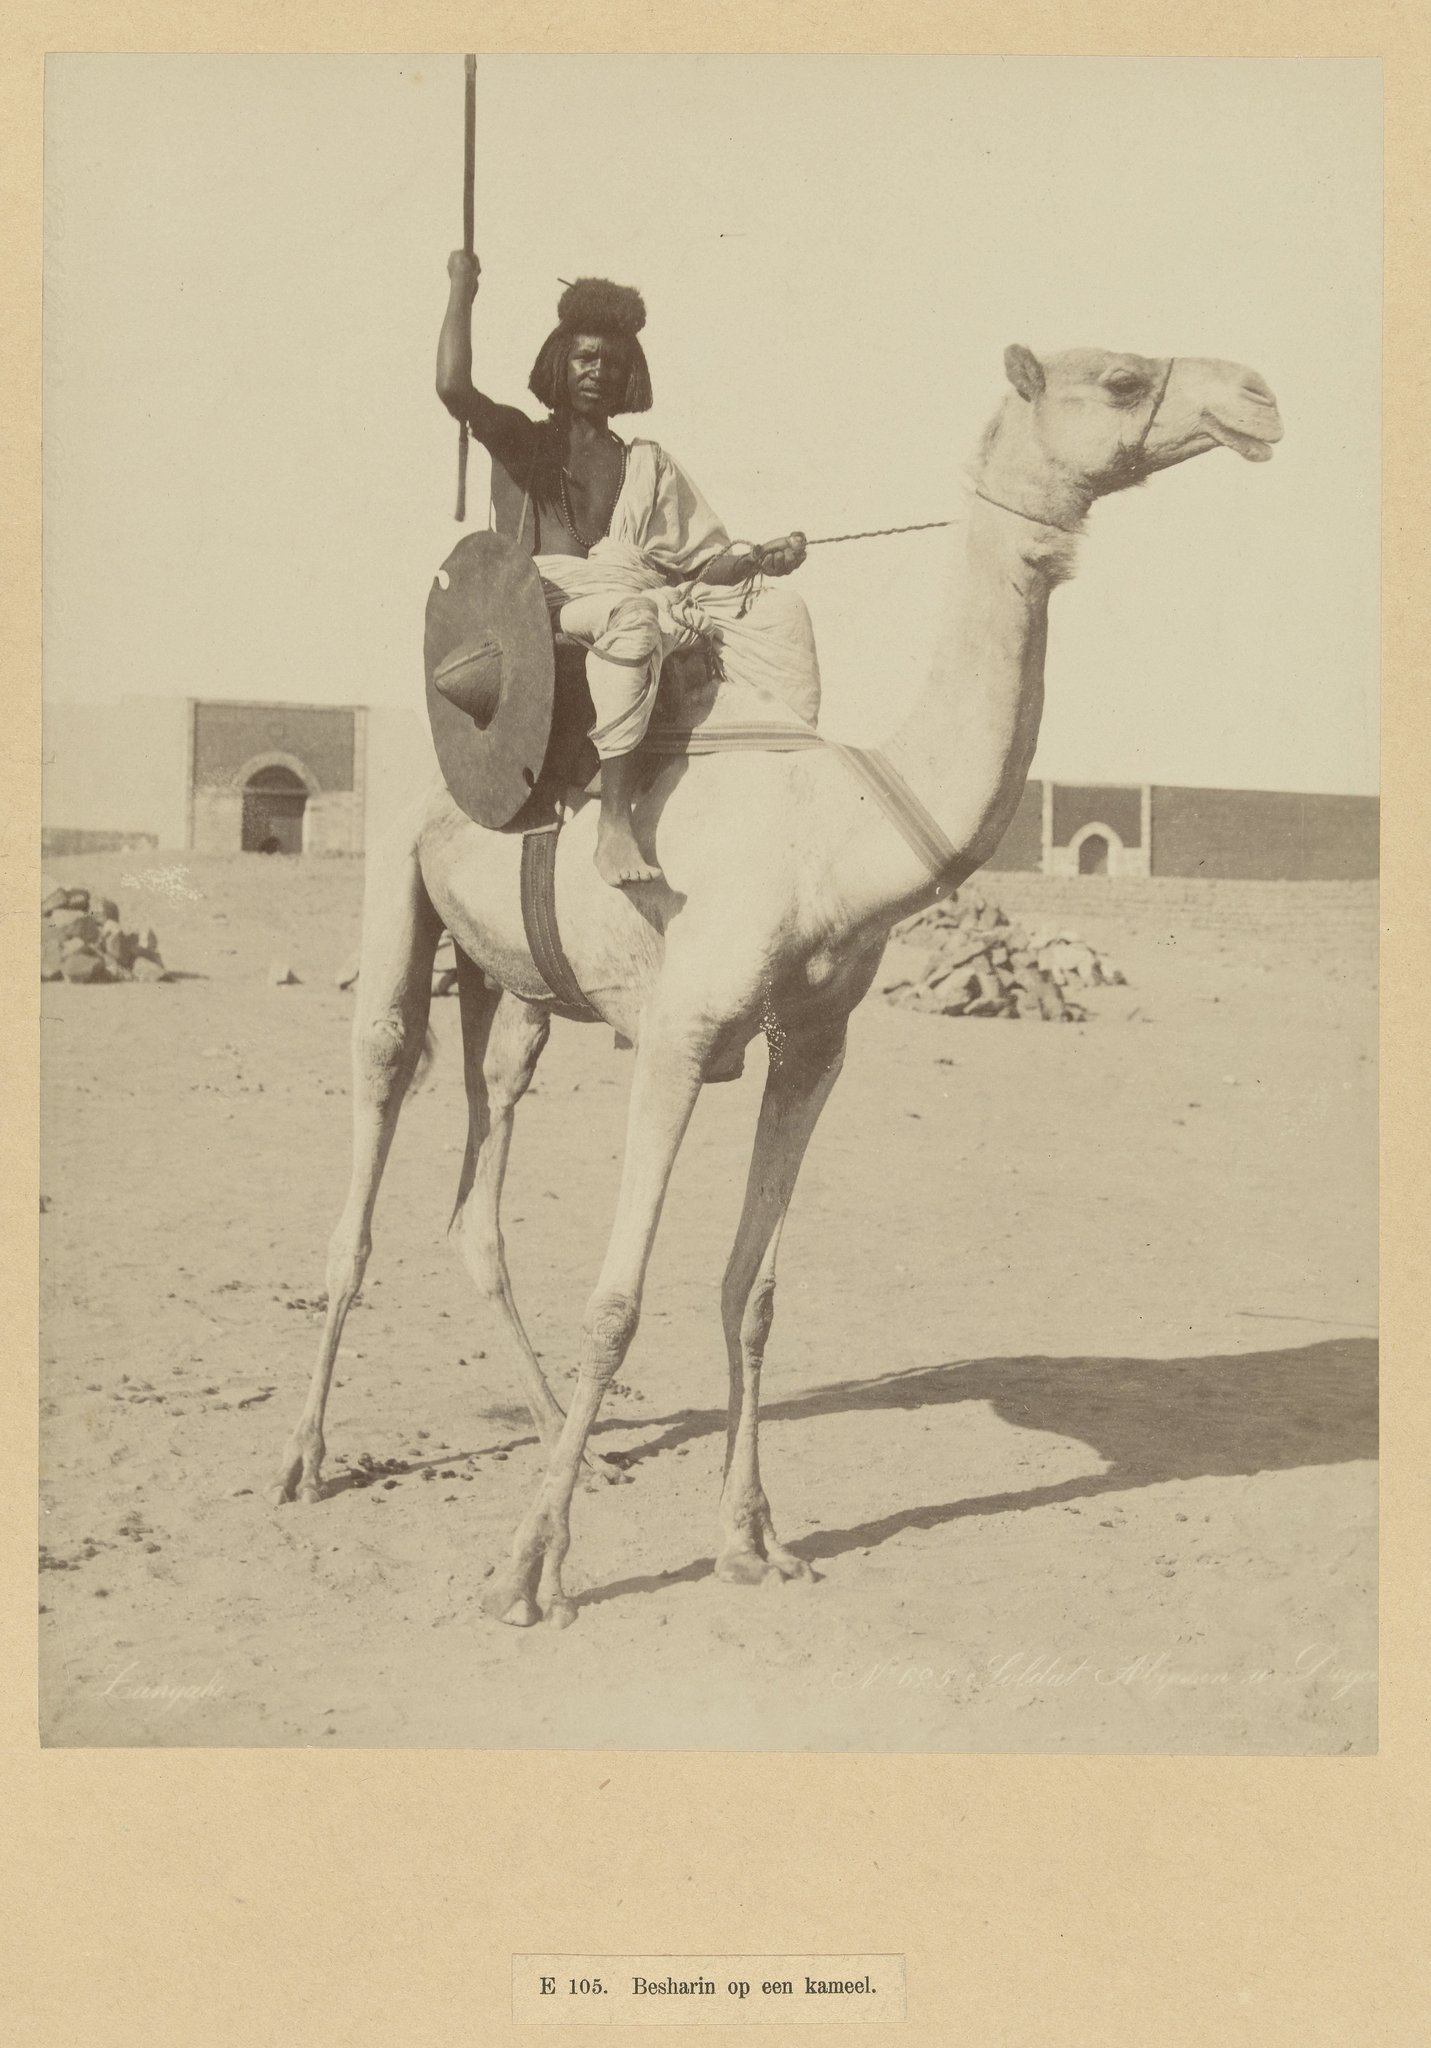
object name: photograph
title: E 105. Besharin op een kameel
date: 1870-1895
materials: cardboard, paper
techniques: albumen print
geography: egypt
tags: hoofed animals: camel, riding on animal other than horse, ass, or mule, casting weapons: spear, historical persons not known by name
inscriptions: check stamp: ‘Bristol/ L.M.’, title: ‘E 105. Besharin op een kameel.’, number: ‘No 625’, stamp: ‘Gemeentelijke bibliotheek/ Rotterdam’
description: Onderdeel van een groep door fotograaf Richard Polak op reis verzamelde foto’s. Deze foto is samen met andere op zijn reizen verzamelde foto's tentoongesteld bij de Rotterdamsche Kunstkring (1895), Arti en Amicitiae te Amsterdam (1897-1898?) en Societeit 't Collegie te Kampen (datum vooralsnog onbekend).